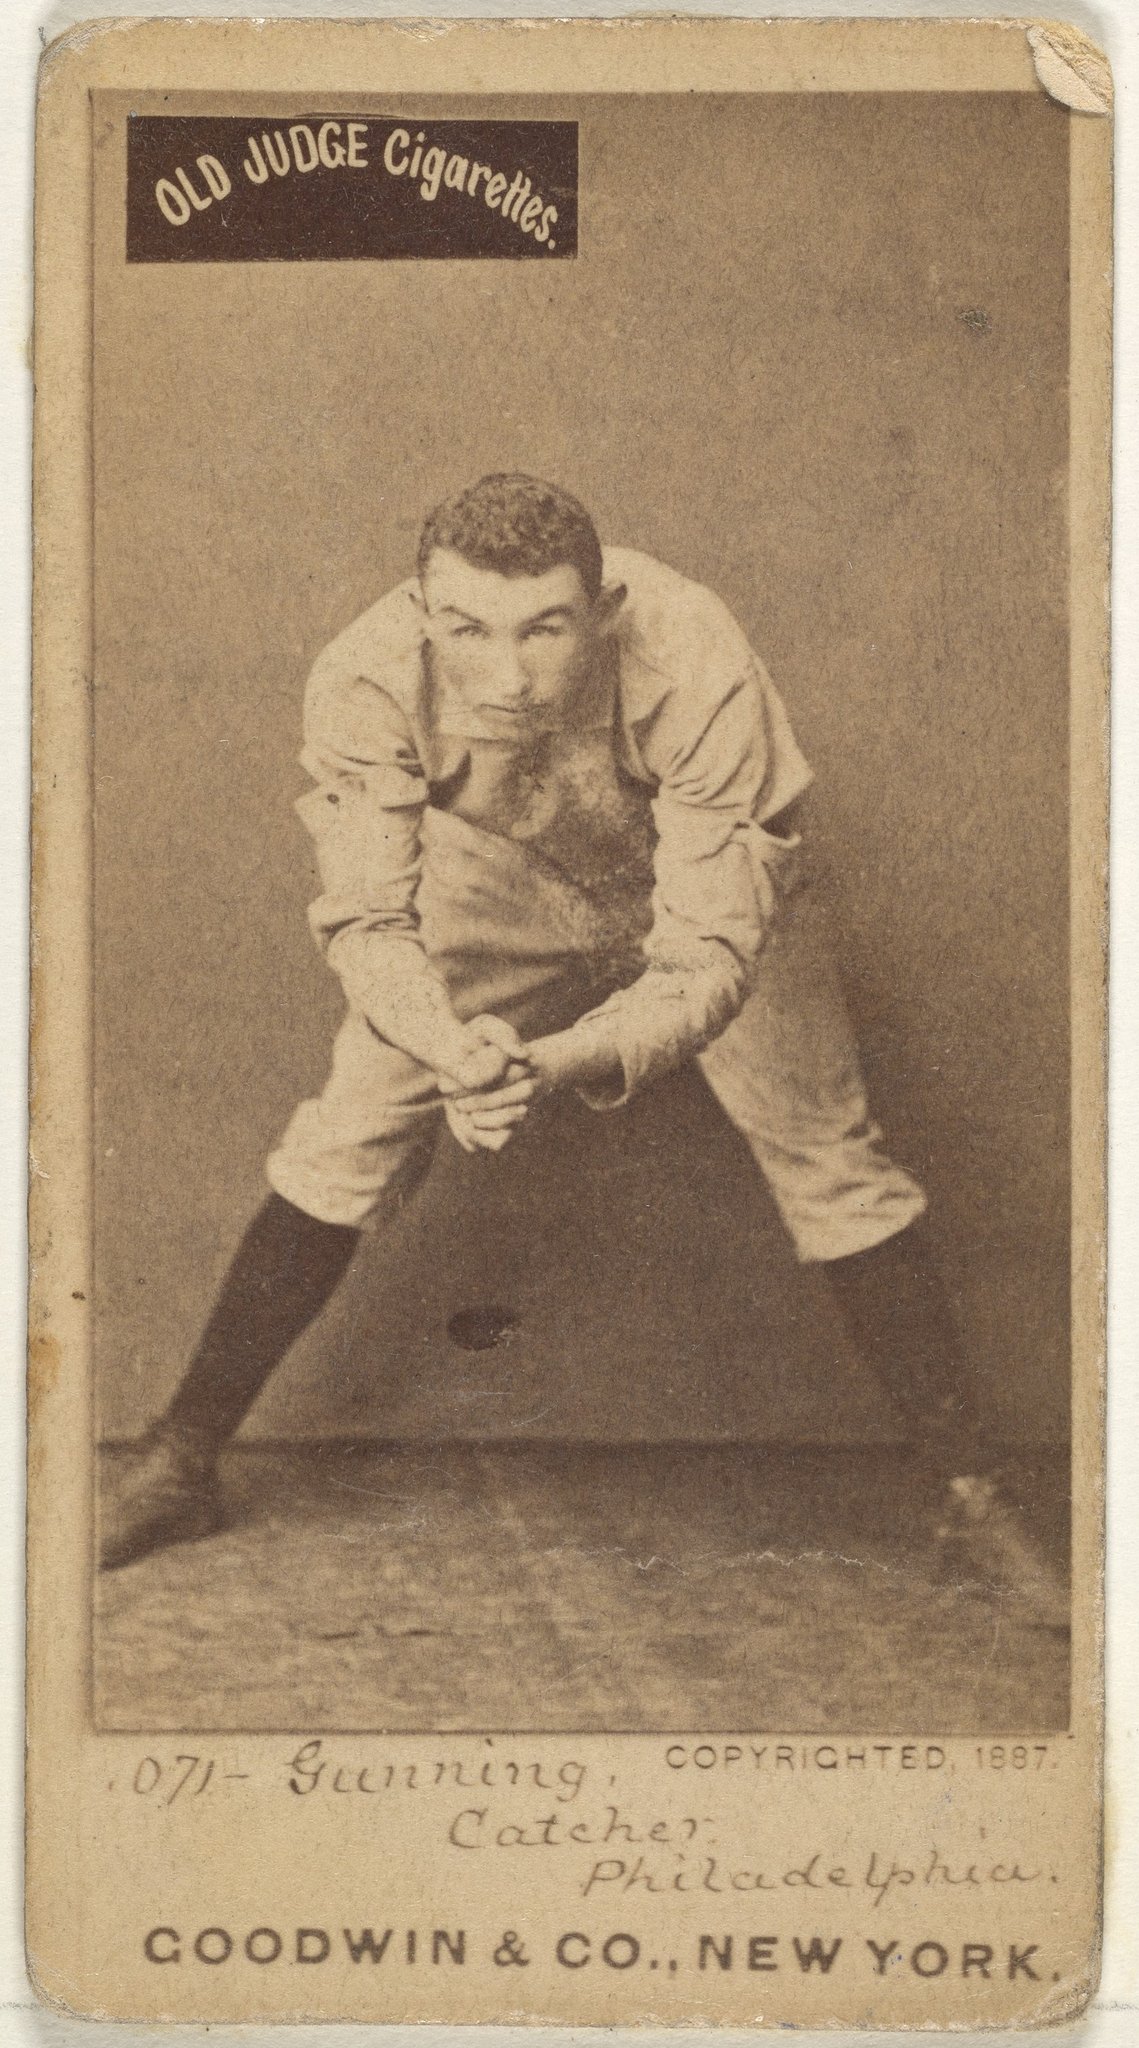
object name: baseball card, photograph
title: Thomas Francis Gunning, Catcher, Philadelphia, from the Old Judge series (N172) for Old Judge Cigarettes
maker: goodwin & company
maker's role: publisher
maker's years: 1850-1950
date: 1887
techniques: albumen silver print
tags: men,portraits,baseball,athletes